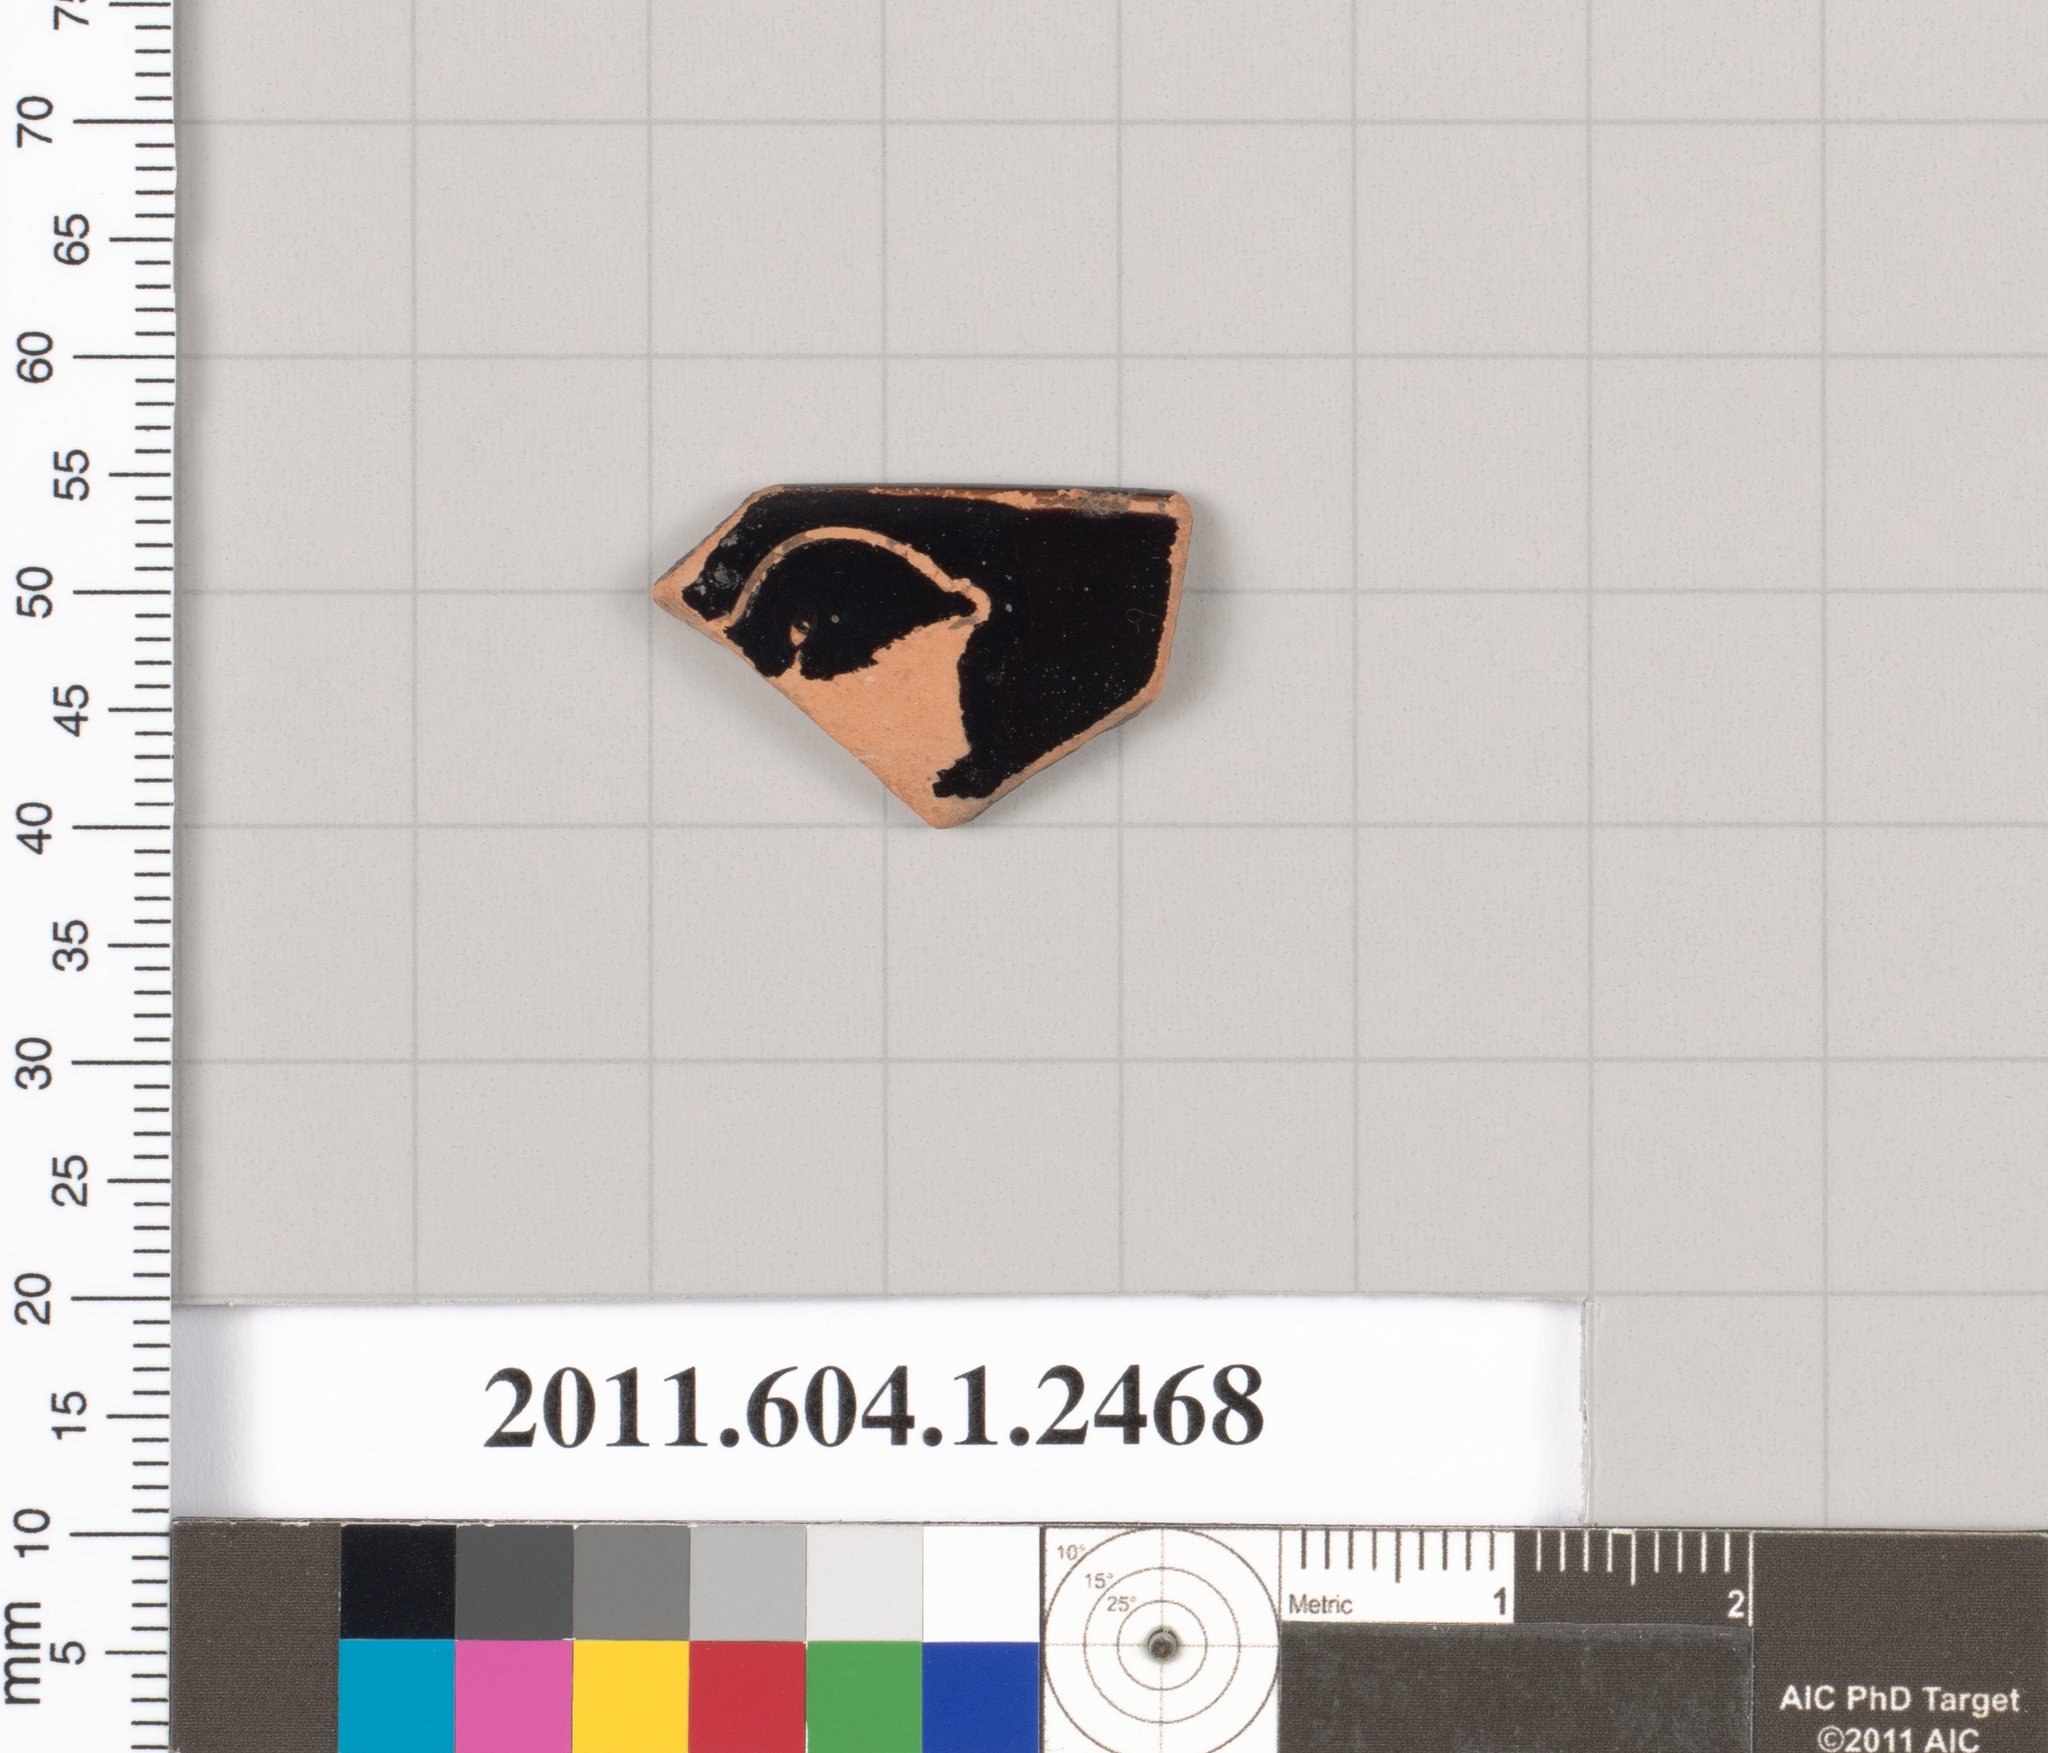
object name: kylix fragment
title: Terracotta rim fragment of a kylix (drinking cup)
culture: greek, attic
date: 475-451 BCE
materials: terracotta